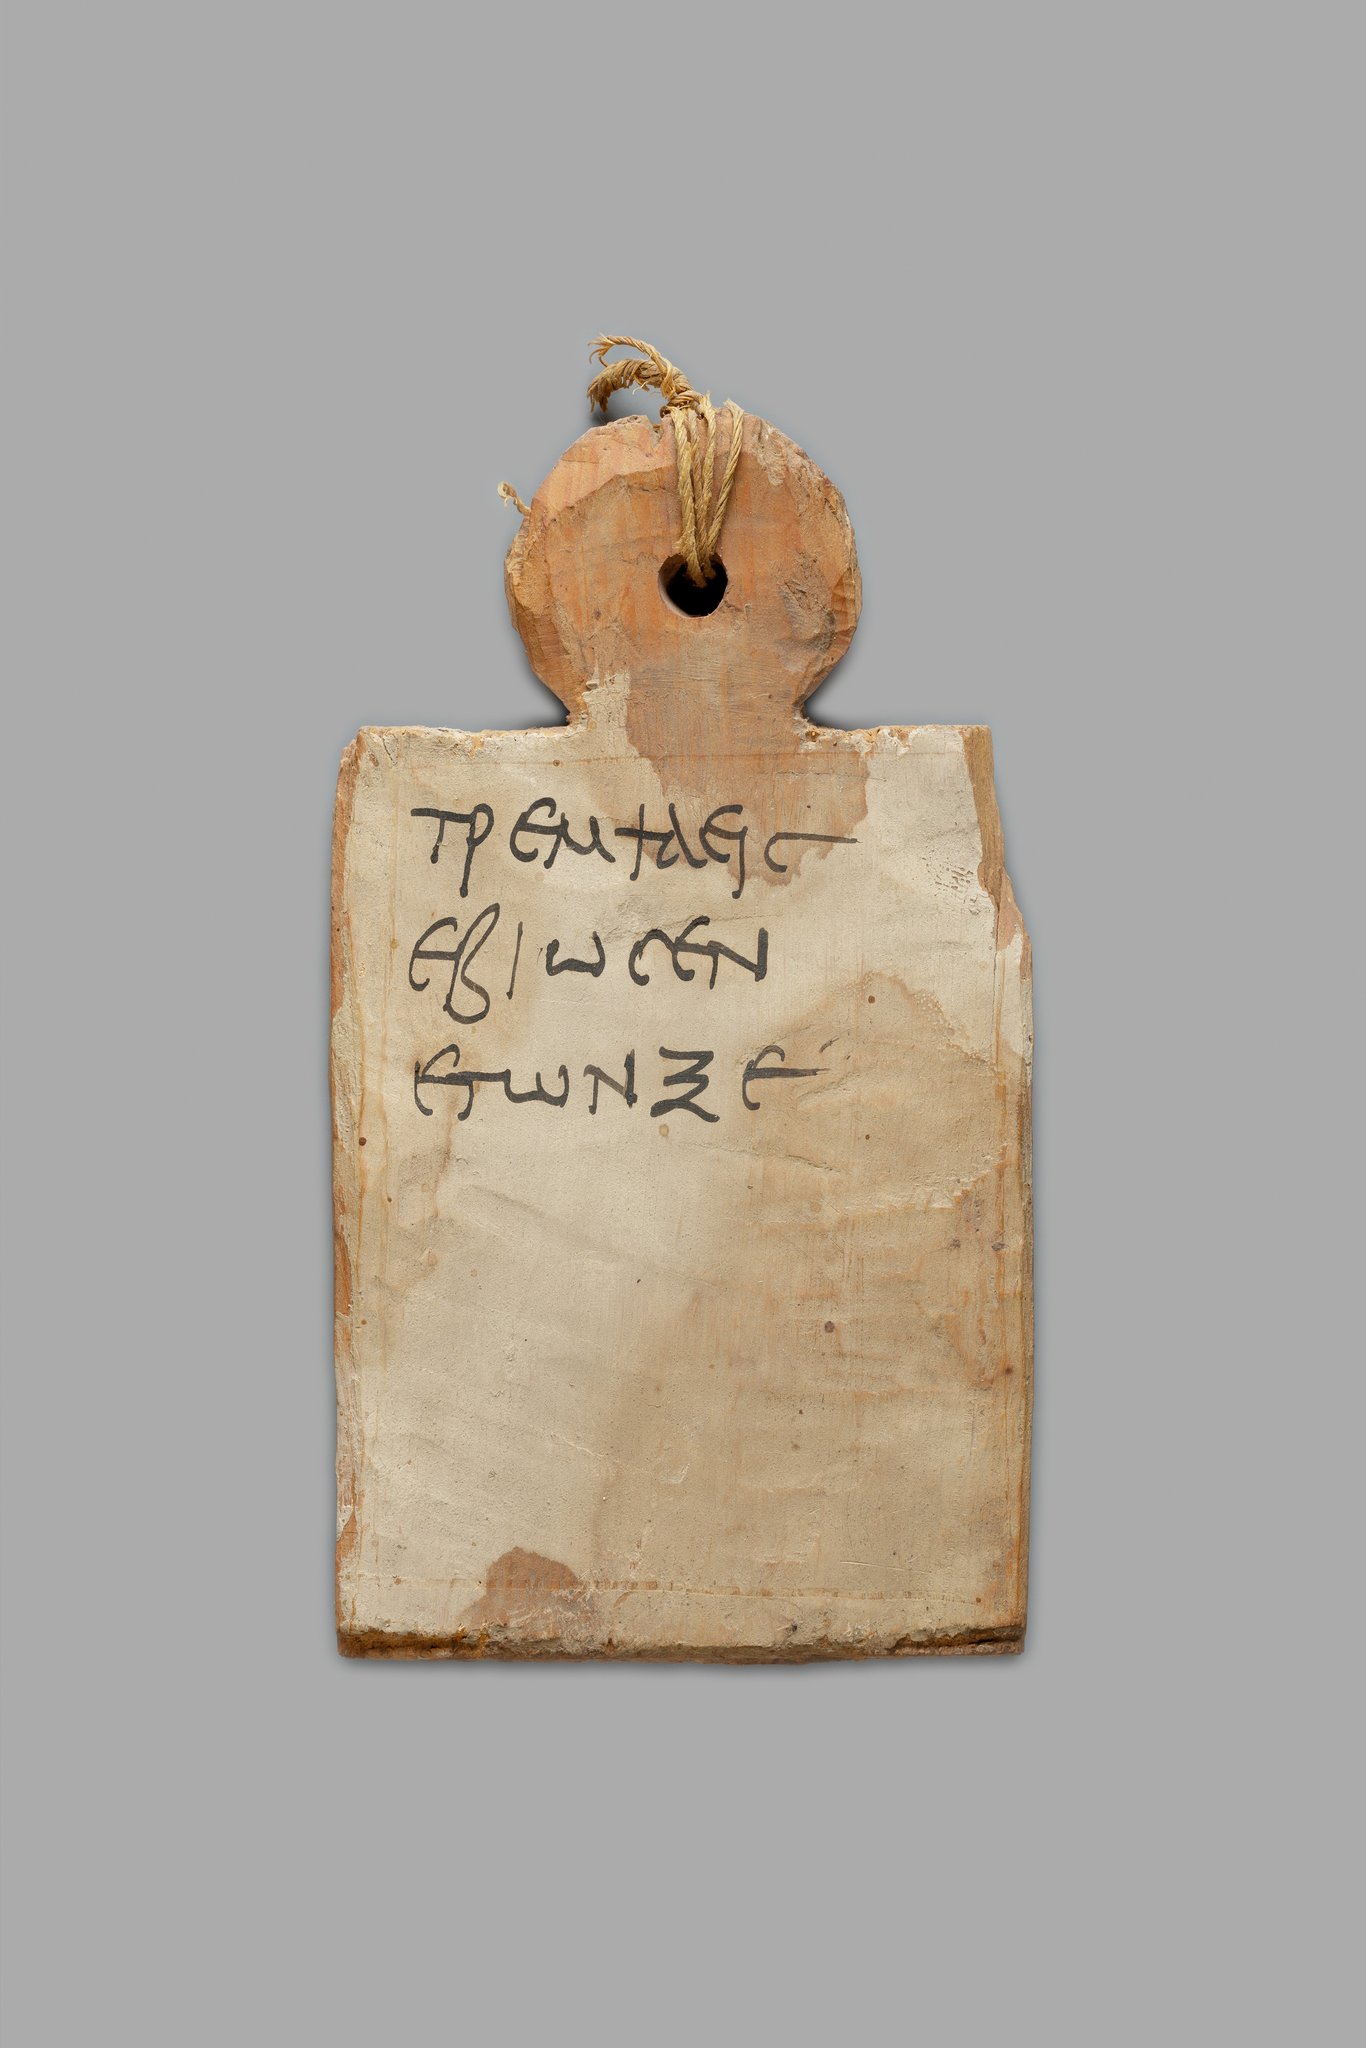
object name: mummy label, trempsaeis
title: Mummy label of the woman Trempsaeis, age 65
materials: ink, wood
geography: upper egypt, thebes